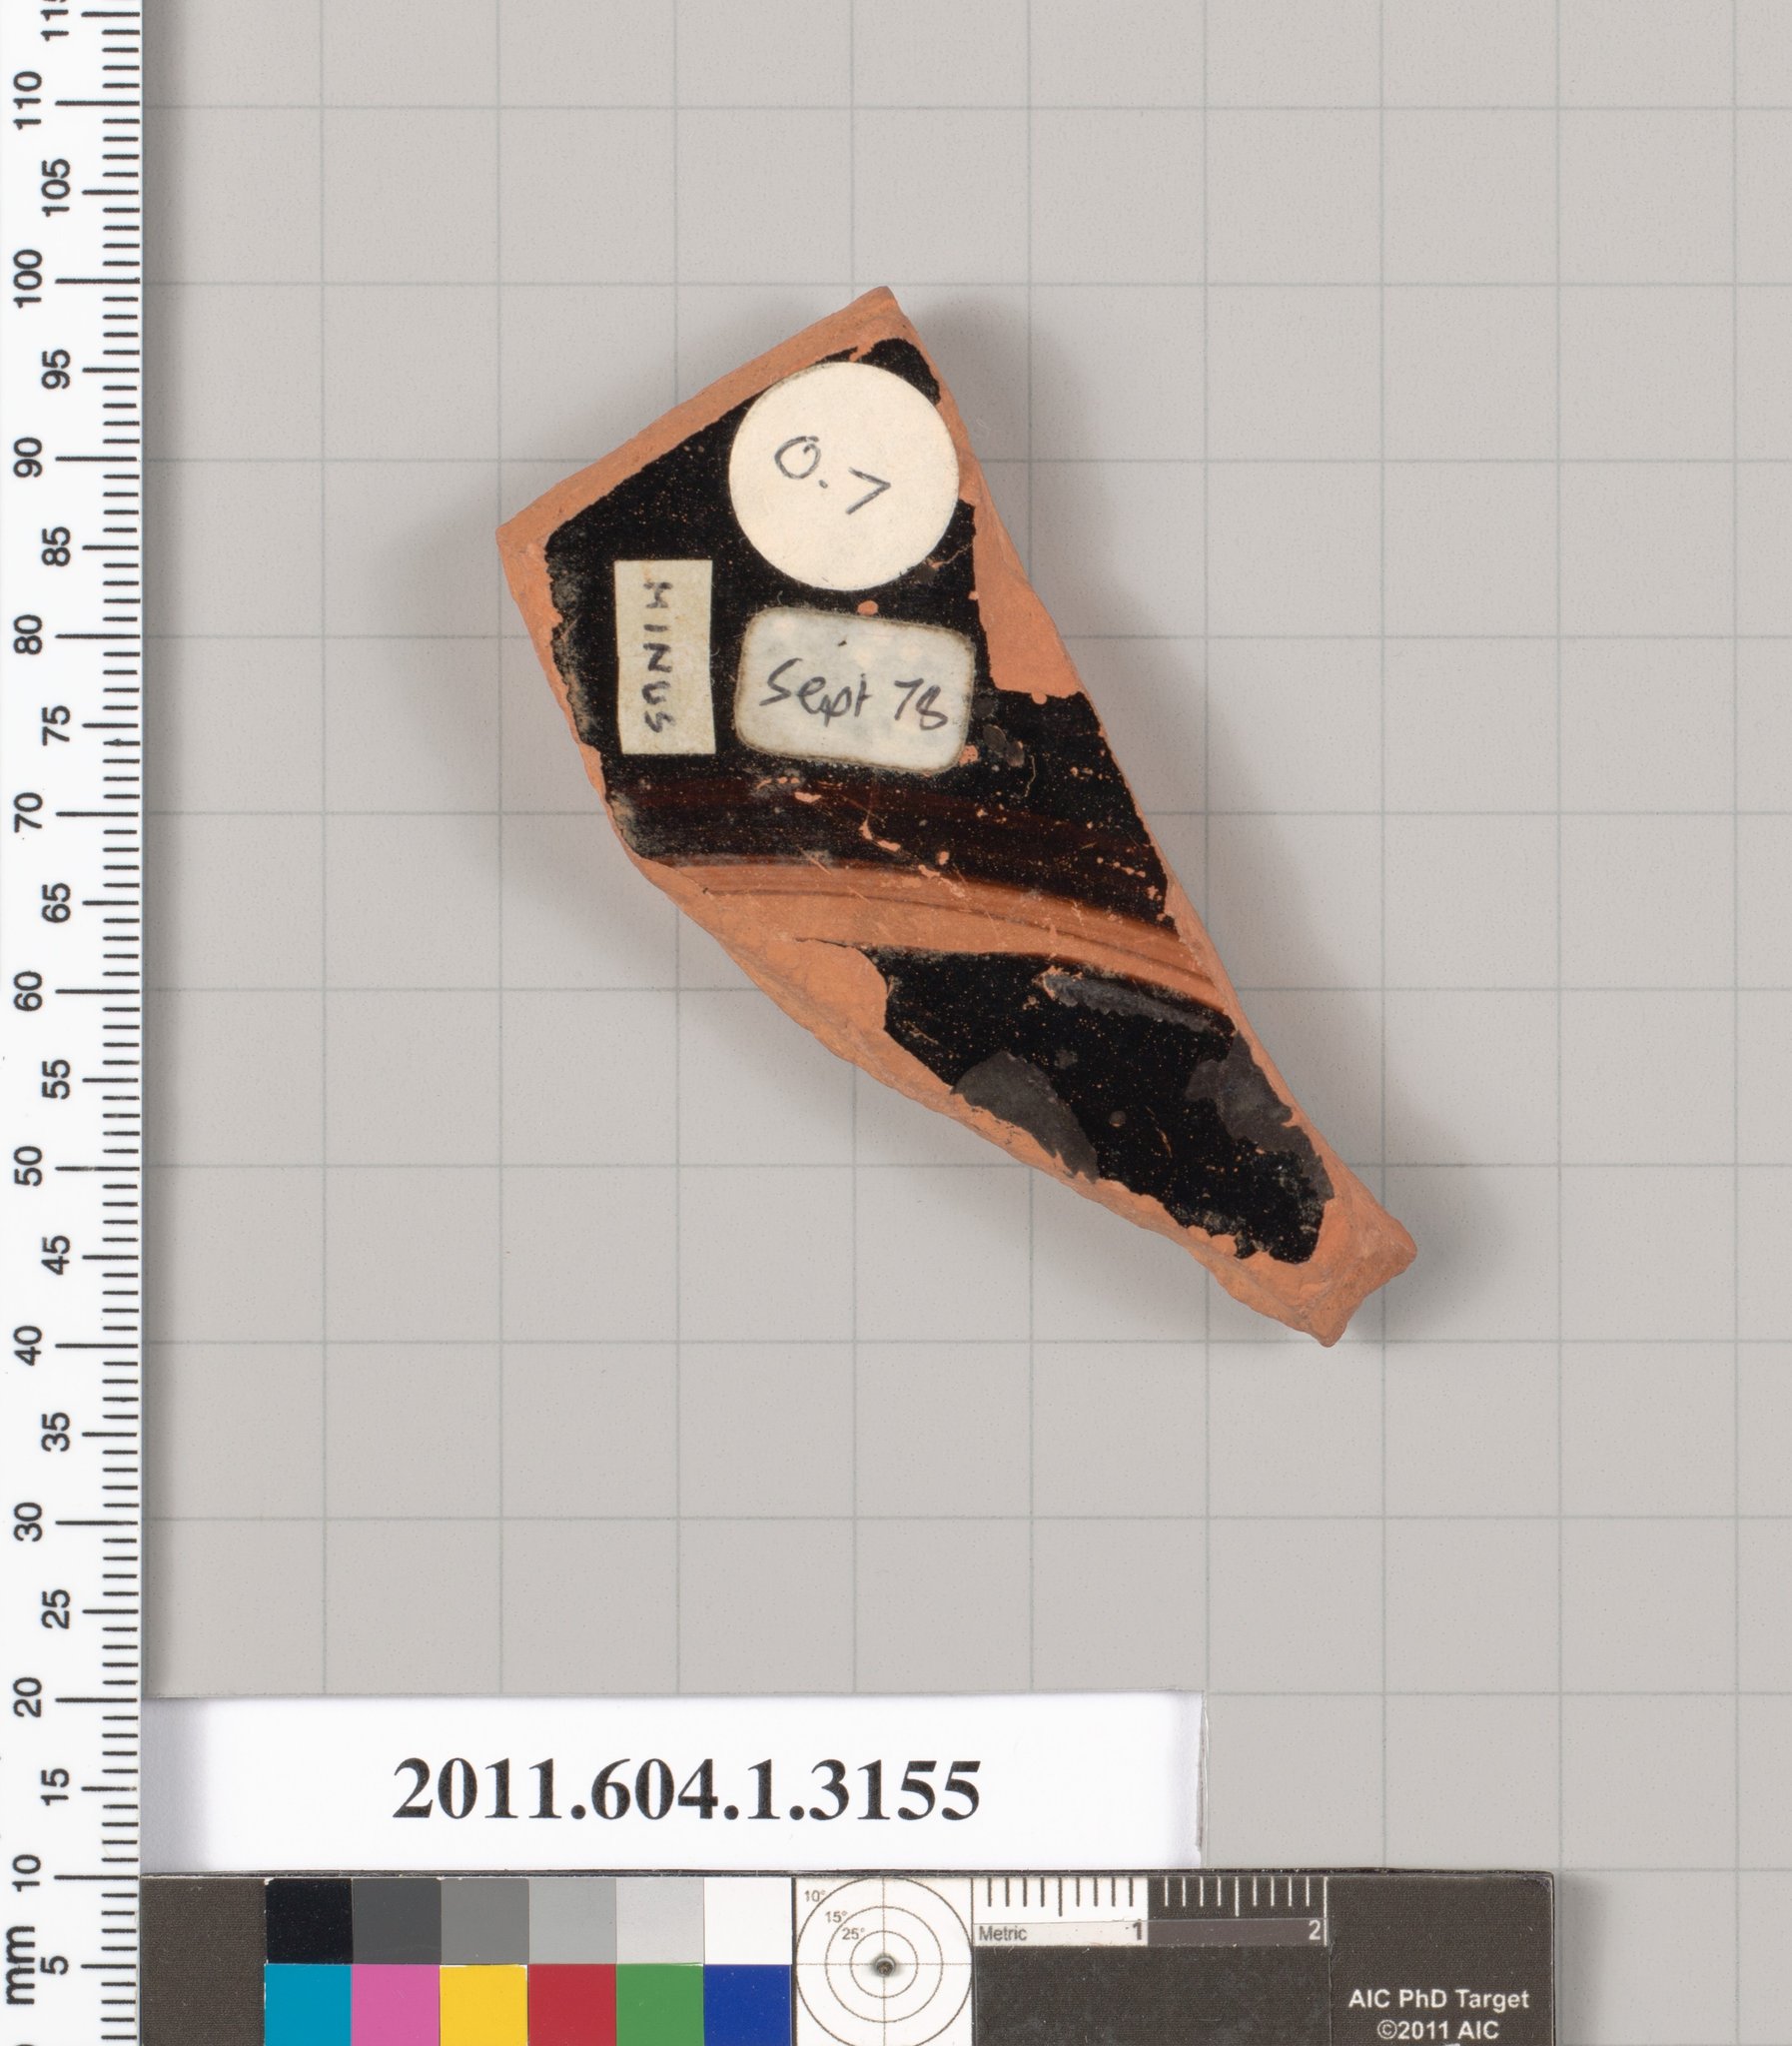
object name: kylix fragment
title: Terracotta fragment of a kylix (drinking cup)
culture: greek, attic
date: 467-435 BCE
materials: terracotta